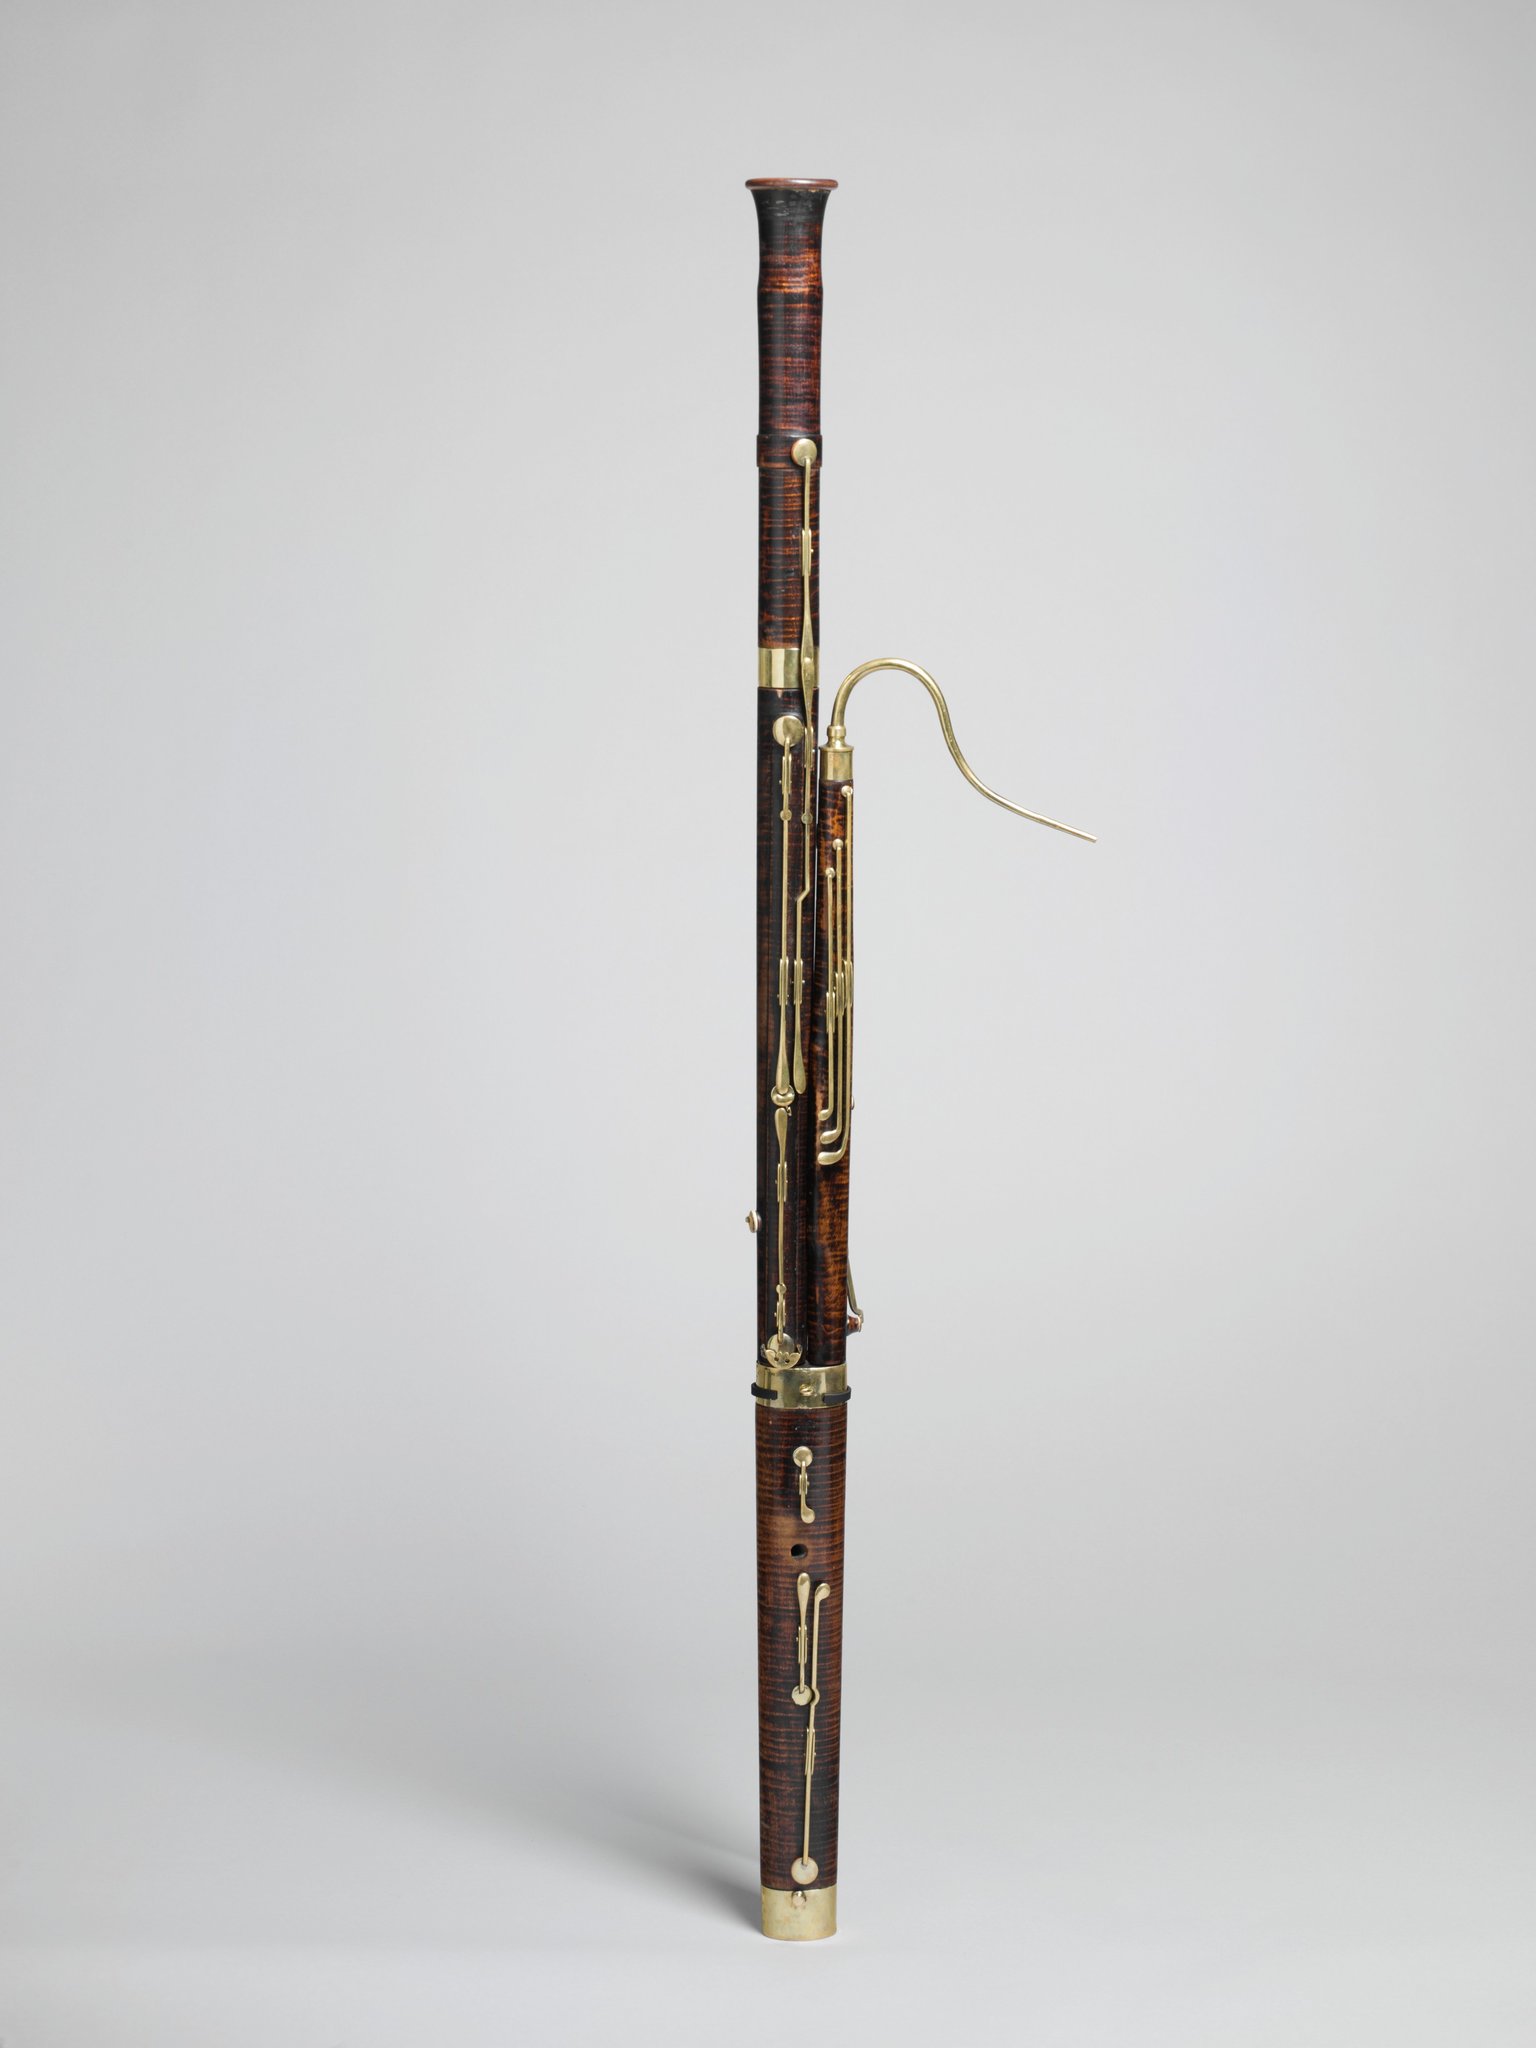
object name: bassoon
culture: german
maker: carl august schaufler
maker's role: maker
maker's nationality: german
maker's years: 1792-1877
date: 1830-1832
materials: brass, wood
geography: germany